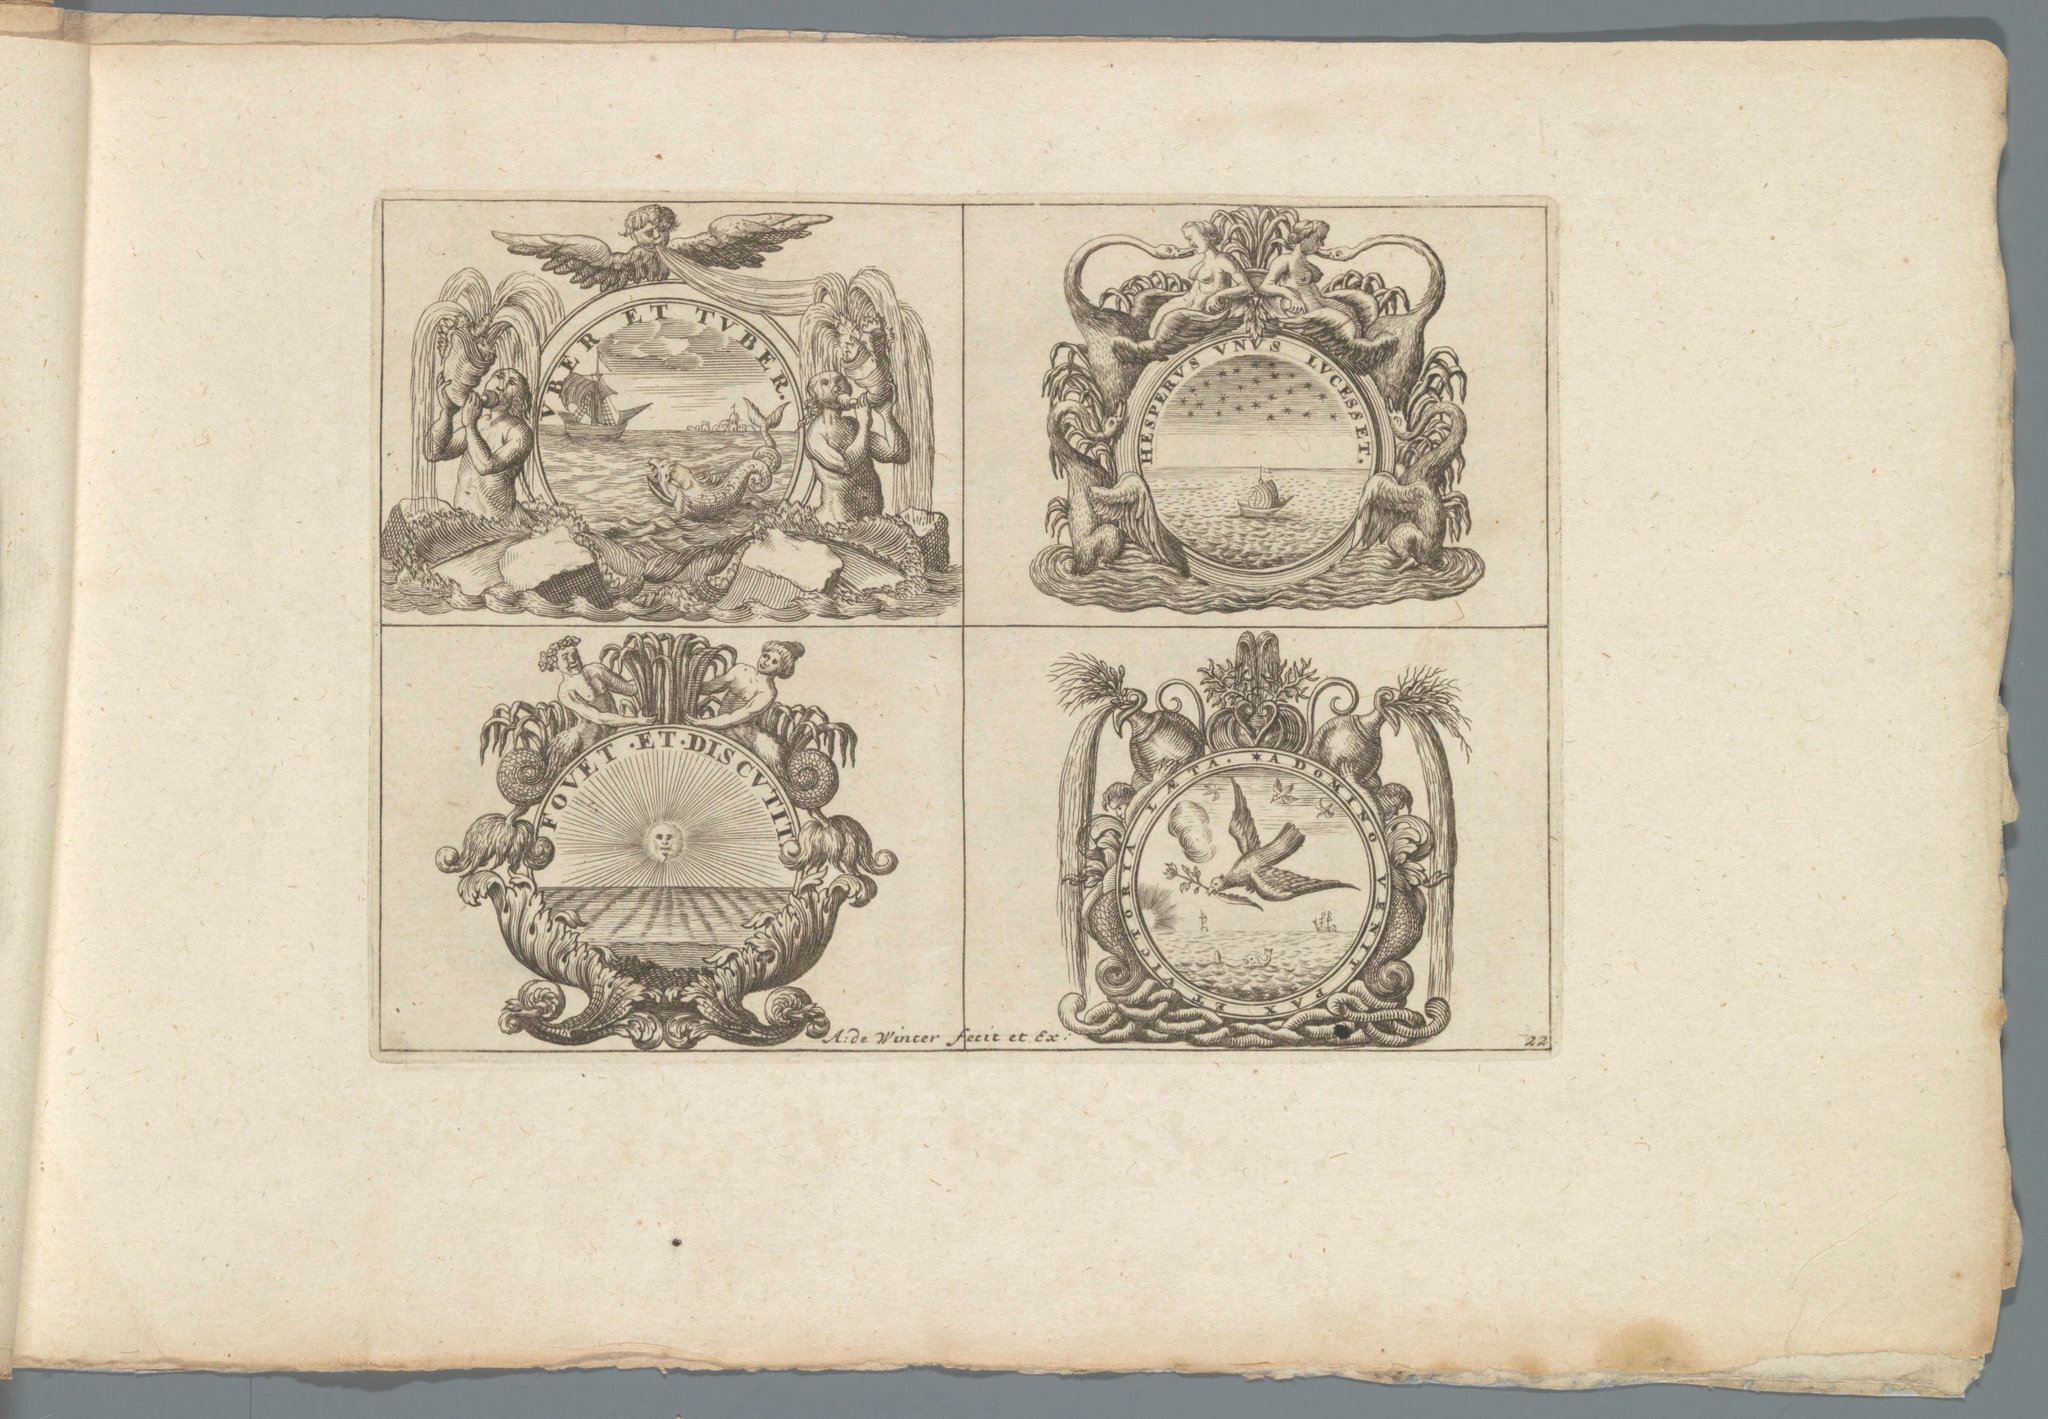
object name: print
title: Livre des plus belles devises enrichies des fleurons et d'autres ornaments nouvellement inventes, etc. ...Tome second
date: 1697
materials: paper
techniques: etching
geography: amsterdam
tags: ornaments ~ art, symbolic representations, allegories and emblems ~mind, spirit, symbols of human life, love: 'frau minne' and other allegories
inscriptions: date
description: Prent nr. 22 van een serie van twaalf genummerde prenten (inclusief titelblad) met deviezen betreffende de liefde en andere levenszaken. De deviezen bestaan uit een pictura en een motto in het Latijn. Deel twee van twee genummerde reeksen. Het is de eerste uitgave (en eerste staat) van de uitgave, voor het adres van Cornelis Danckerts II en de toevoeging van Nederlandse teksten.